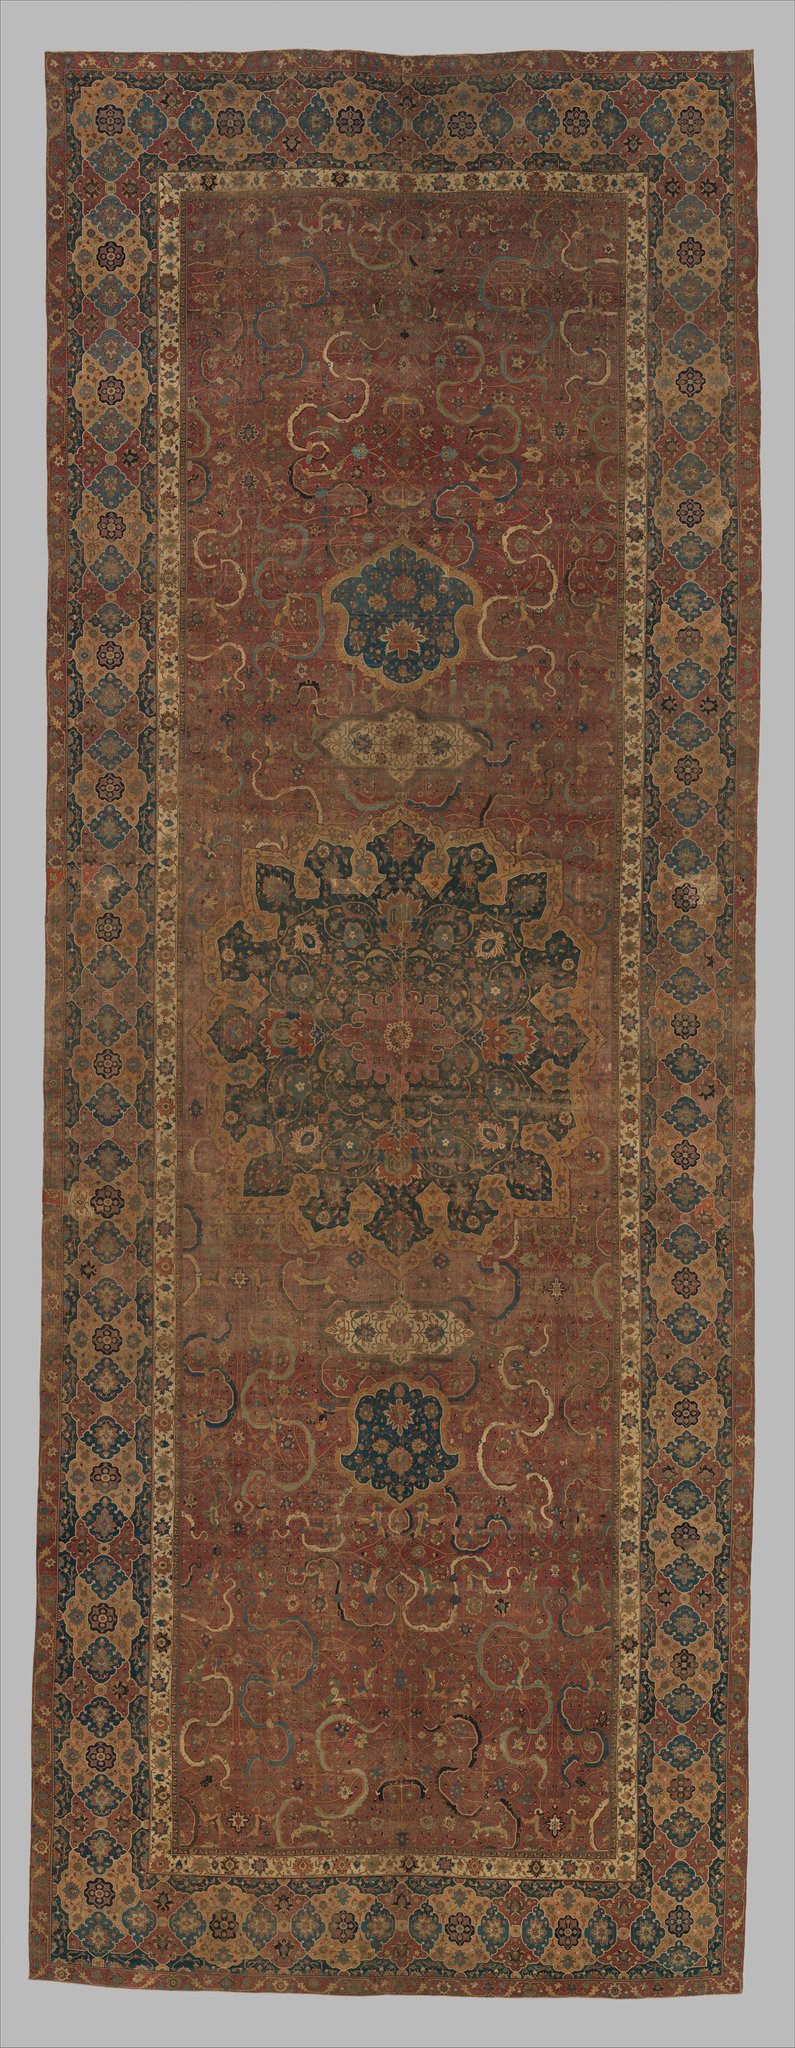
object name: carpet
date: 1501-1600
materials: cotton, wool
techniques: asymmetrically knotted pile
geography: northwestern iran